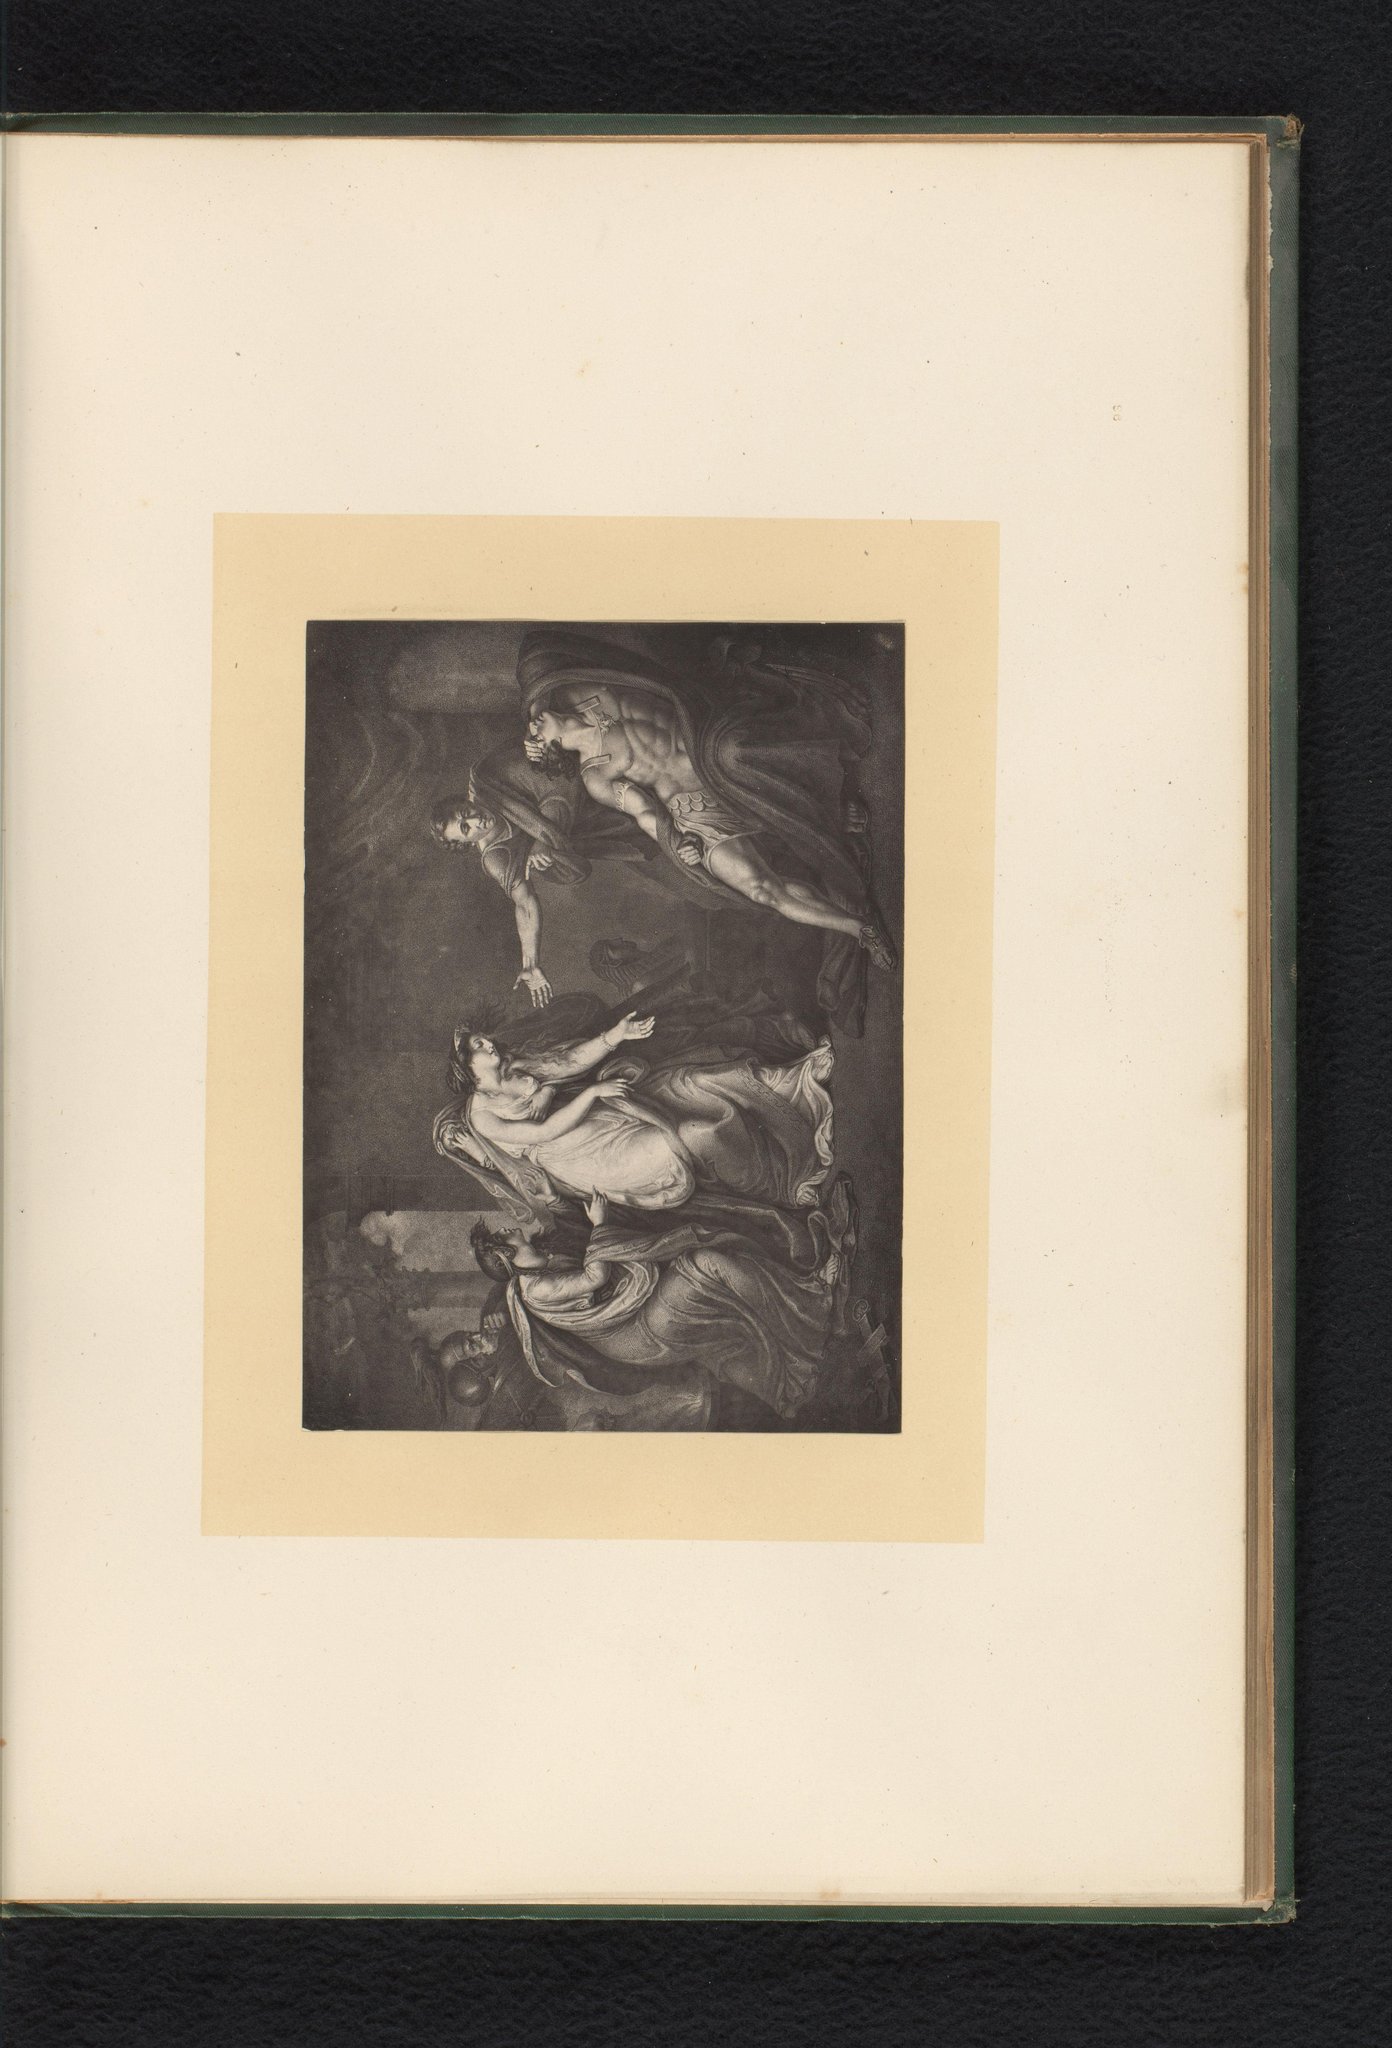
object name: reproduction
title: Antony and Cleopatra, Act III, Scene 9: Alexandria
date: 1874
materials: paper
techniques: woodburytype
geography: london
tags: theatre, theatrical performance